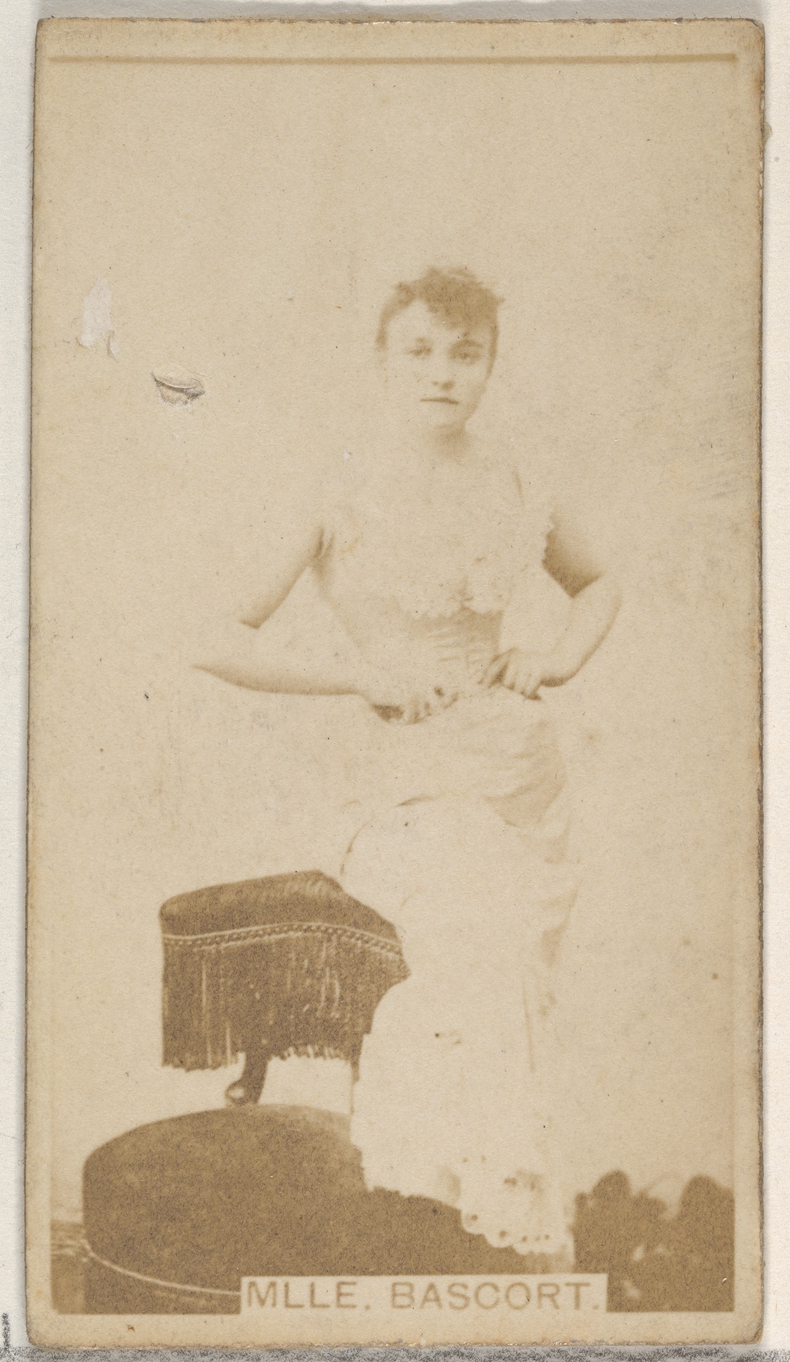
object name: photograph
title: Mlle. Bascort, from the Actors and Actresses series (N45, Type 8) for Virginia Brights Cigarettes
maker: allen & ginter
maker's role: publisher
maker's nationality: american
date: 1888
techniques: albumen silver print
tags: portraits,women,actresses